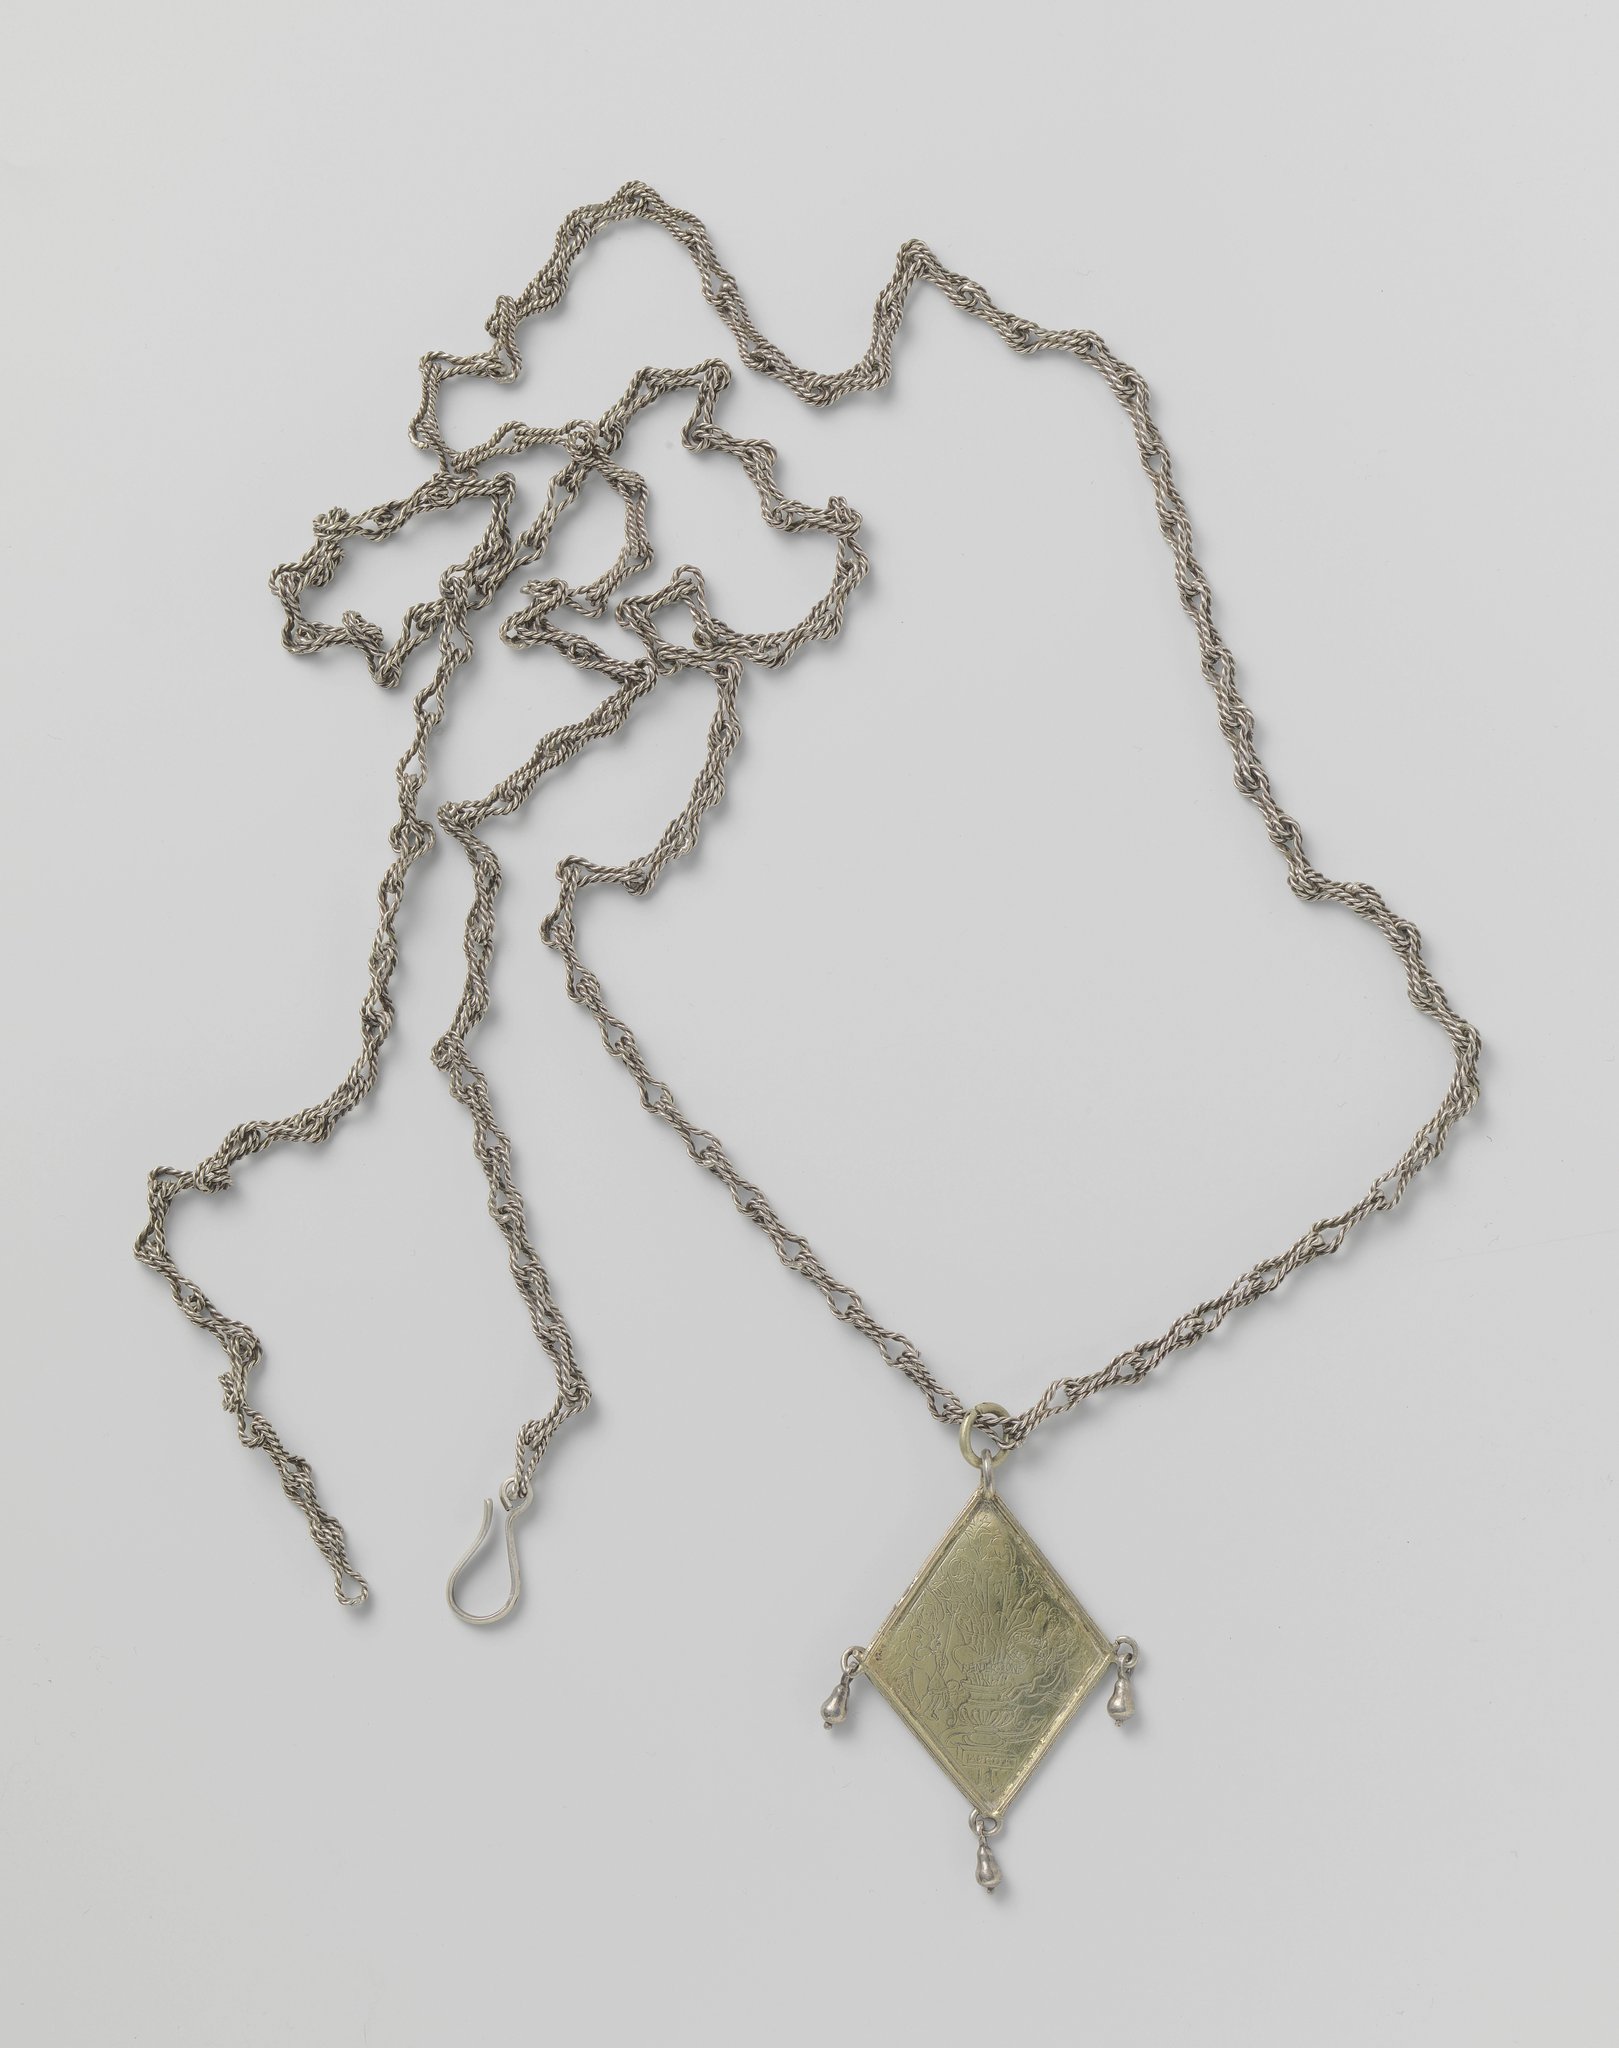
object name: keten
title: Chain of the Veere Chamber of Rhetoric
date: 1530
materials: silver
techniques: gilding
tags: the annunciation: mary, usually reading, is visited by the angel (sometimes a woman overhears the conversation)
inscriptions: : ‘In reinder jonste groeiende’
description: In the late Middle Ages, many Dutch towns witnessed the emergence of societies of amateur orators and poets, the so-called rederijkers (derived from the French word rhétoriqueur, or ‘rhetorician’). This ceremonial chain was worn by the dean of Missus Scholieren, the chamber of rhetoric in Veere. It is one of the oldest rhetorician chains to have survived.